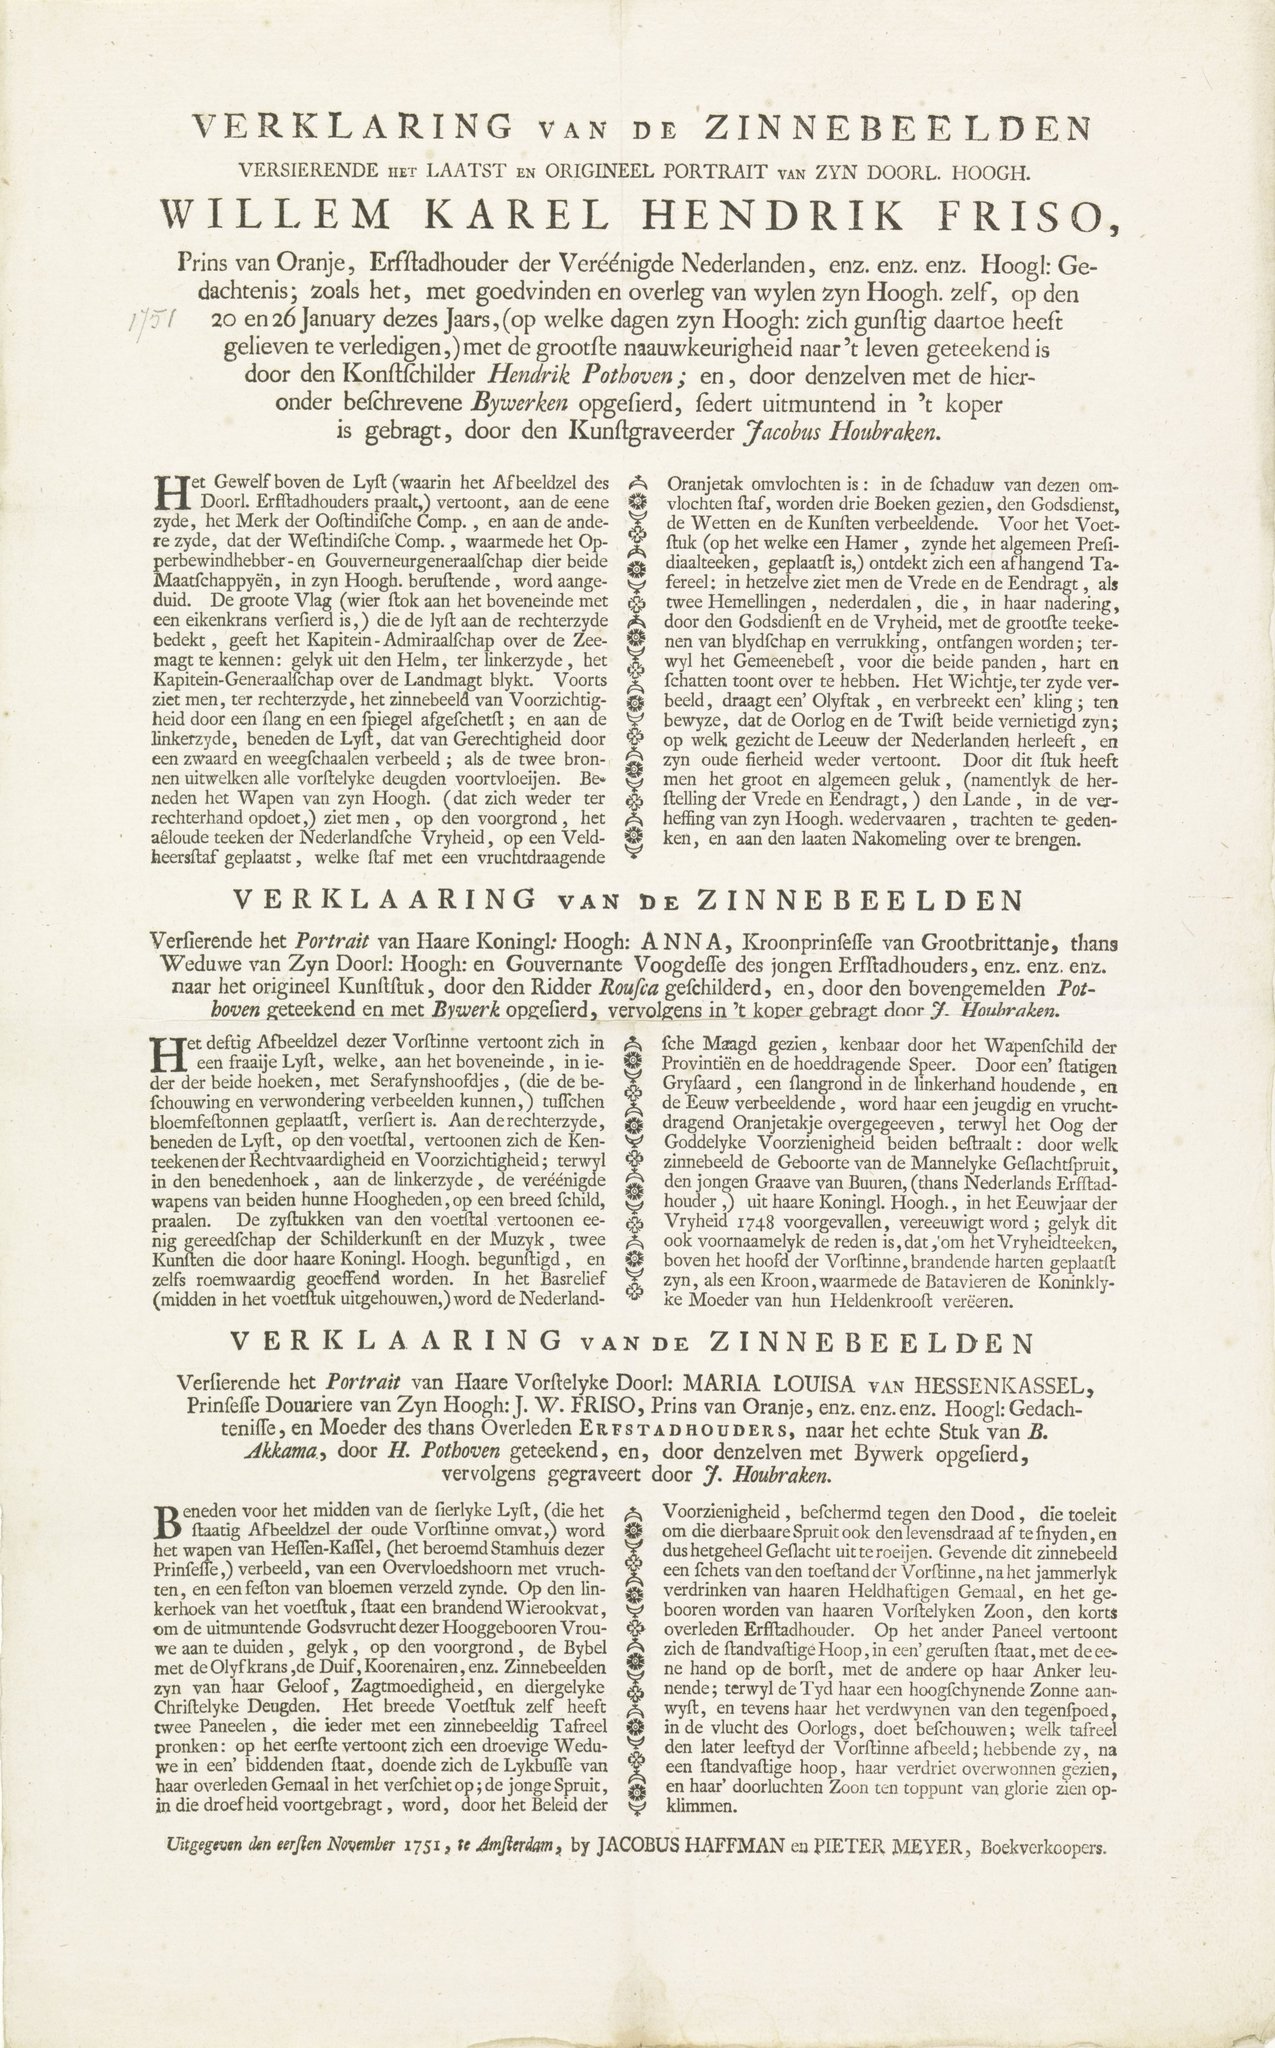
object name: text sheet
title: Tekst bij de portretten van Willem IV, prins van Oranje-Nassau, Anna van Hannover en Maria Louisa van Hessen-Kassel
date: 1751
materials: paper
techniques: letterpress printing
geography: amsterdam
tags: willem iv (prins van oranje-nassau), anna van hannover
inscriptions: collector's mark: Lugt 2228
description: De hier vermelde titel verwijst naar de hoogst verkregen titel van de geportretteerde, niet per se naar de titel die de geportretteerde op deze voorstelling draagt.